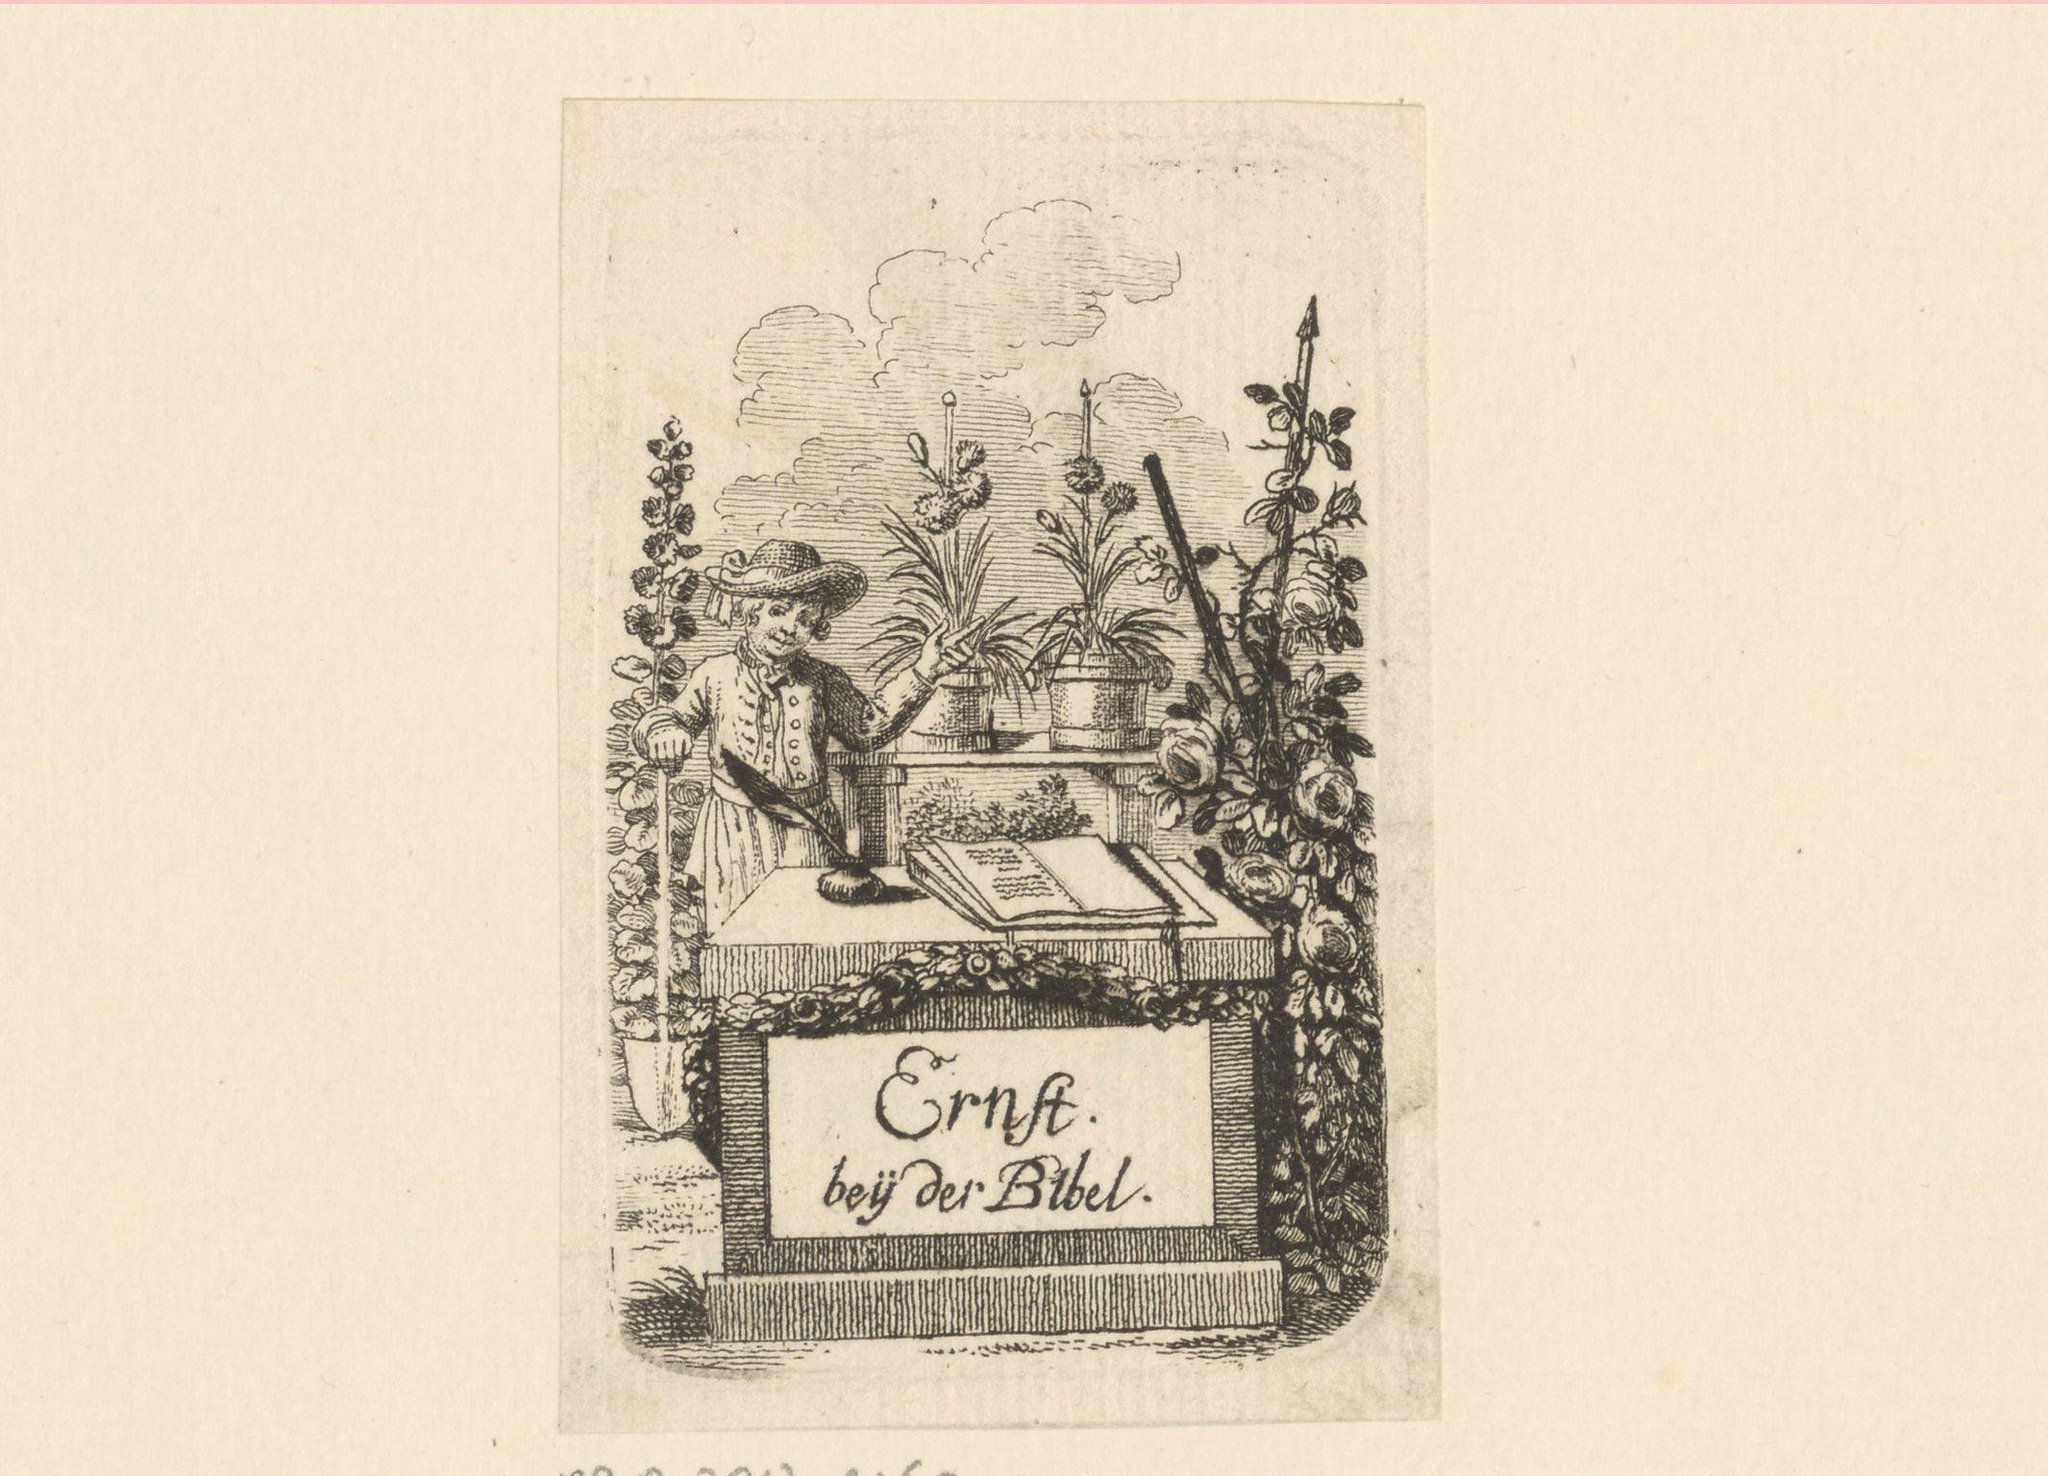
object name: bookplate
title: Ex libris van Ernst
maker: johann rudolph schellenberg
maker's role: print maker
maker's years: 1740-1806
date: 1759-1801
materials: paper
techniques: etching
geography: switzerland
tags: flowers, quill, boy (child between toddler and youth), garden, book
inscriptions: inscription: ‘Ernst / Schellenberg sc. / Gerster 610’